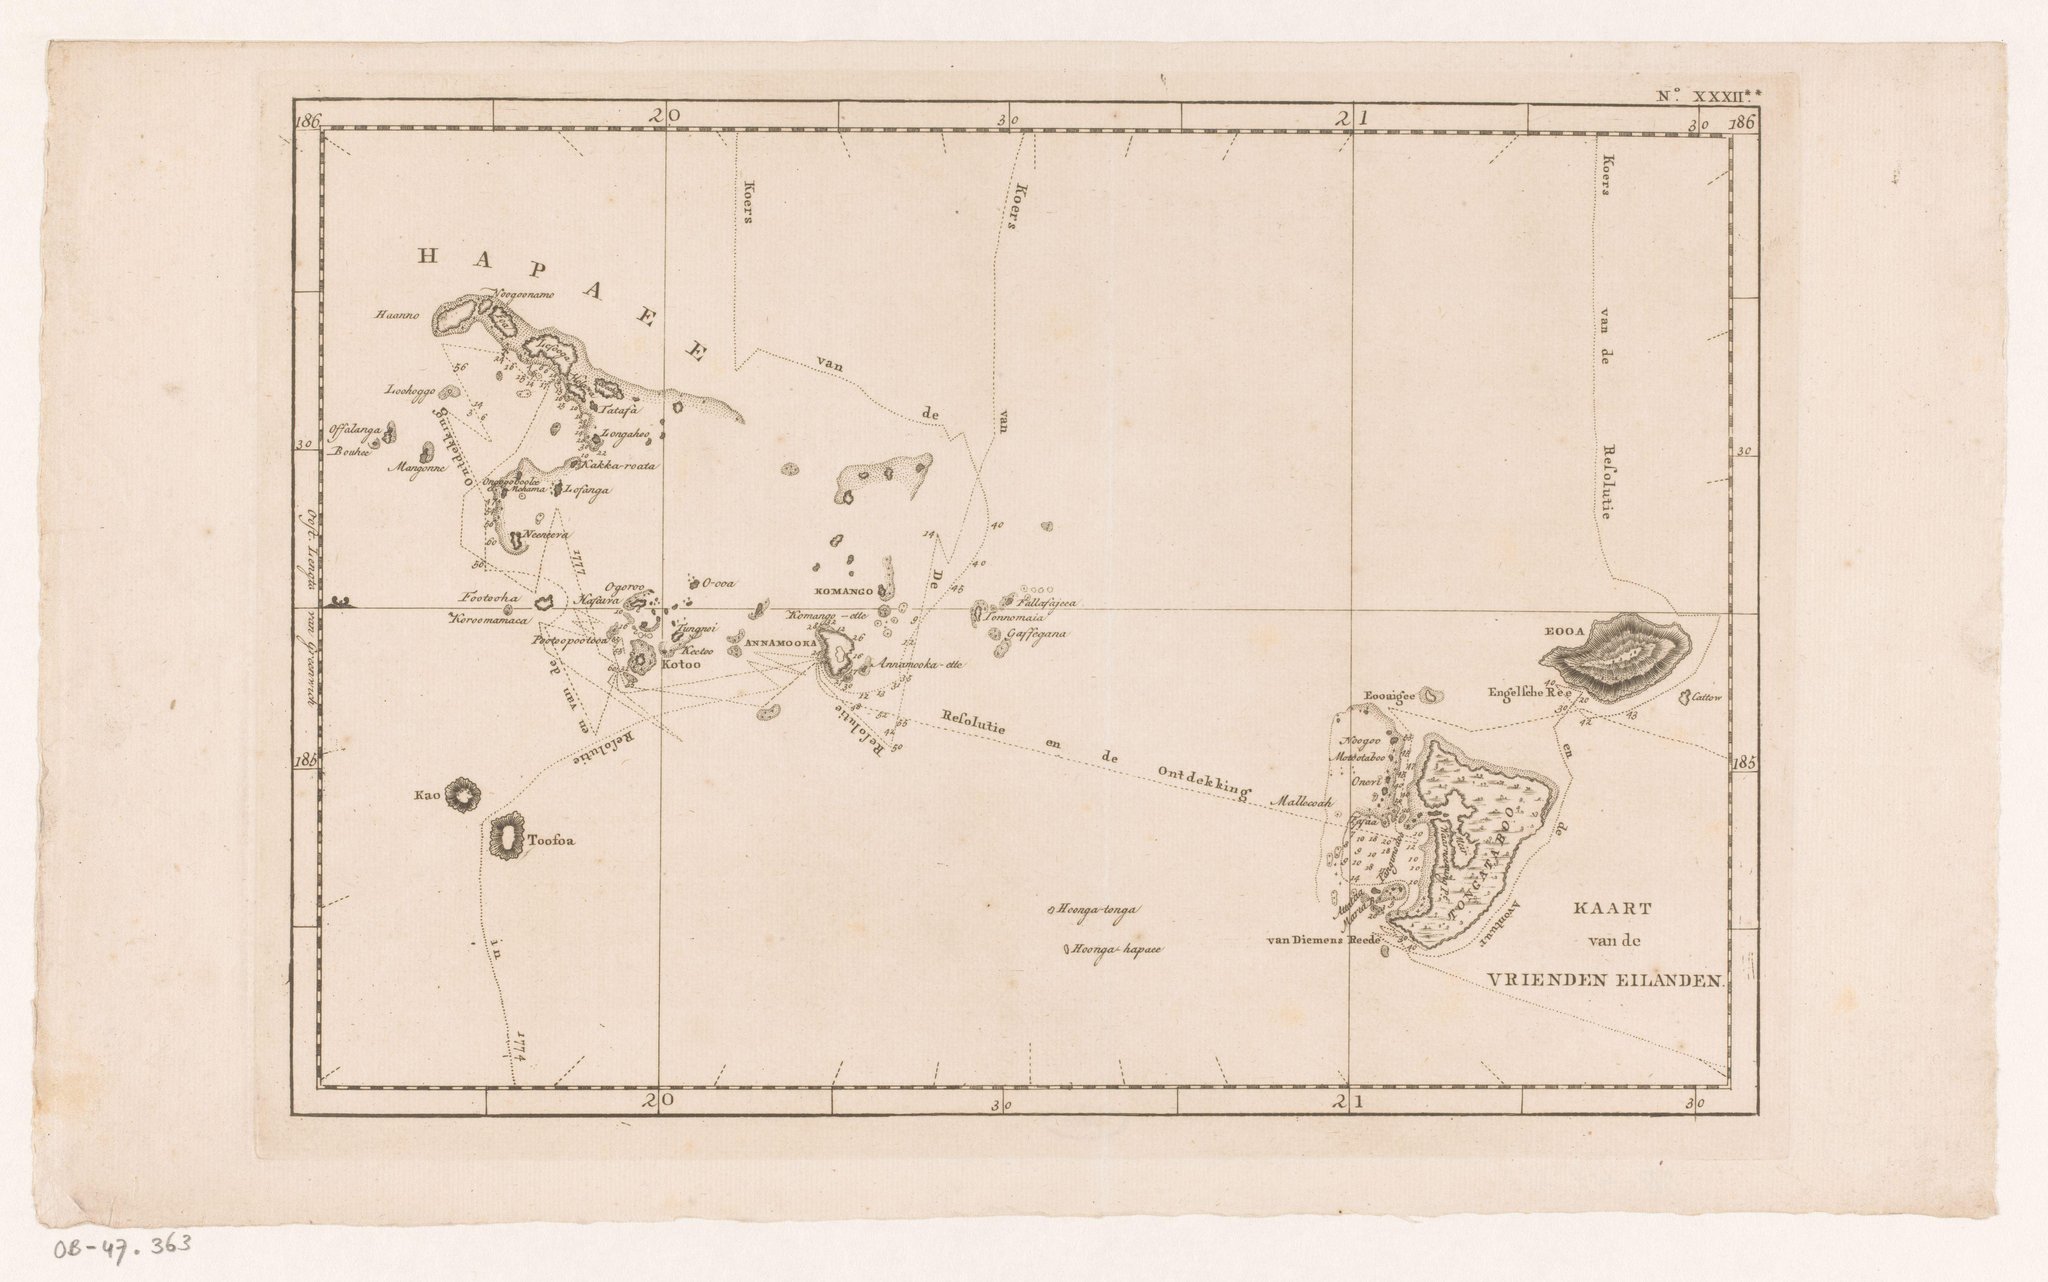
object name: map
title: Kaart van de Tonga Archipel in Polynesië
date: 1801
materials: paper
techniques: etching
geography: leiden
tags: island, maps, atlases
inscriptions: collector's mark: Lugt 2228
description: Prent uit: Cook, James. Reize rondom de Waereld (...) met kaarten en plaaten. [Vertaald uit het Engels door] Jan David Pasteur. Leiden: Honkoop, Amsterdam: Allart, Den Haag: Van Cleef, 1801, dl. 9, p. 89.